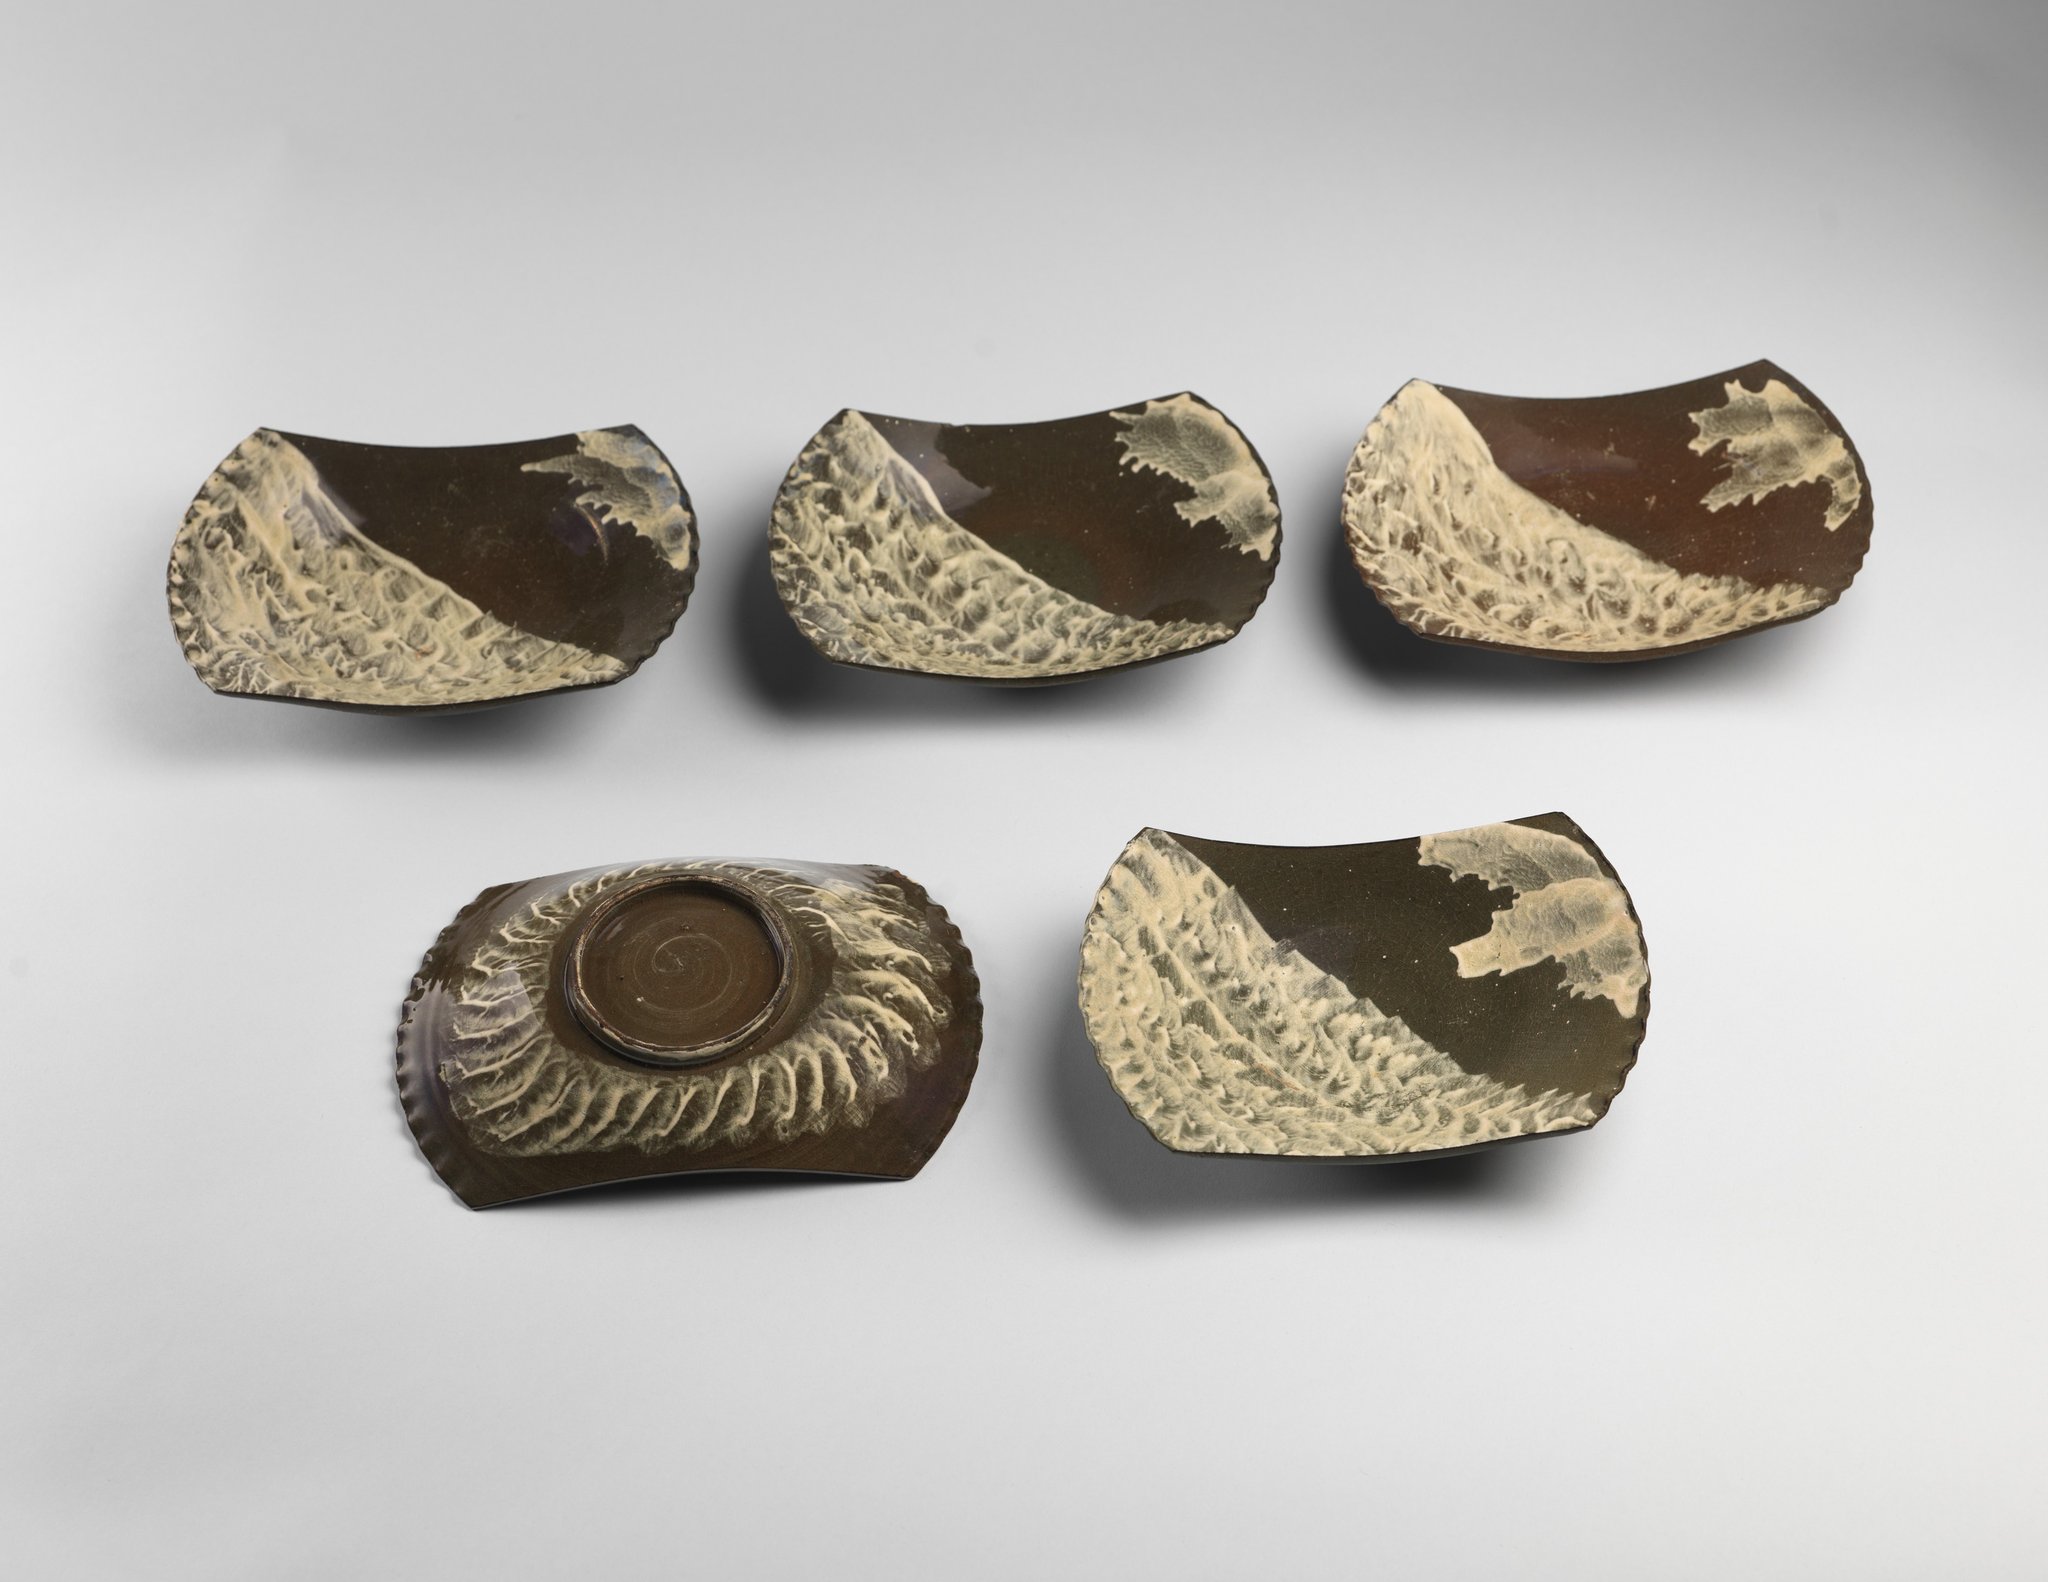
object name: dish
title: Five Dishes with Wave Design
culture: japanese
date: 1701-1750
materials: stoneware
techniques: glazing